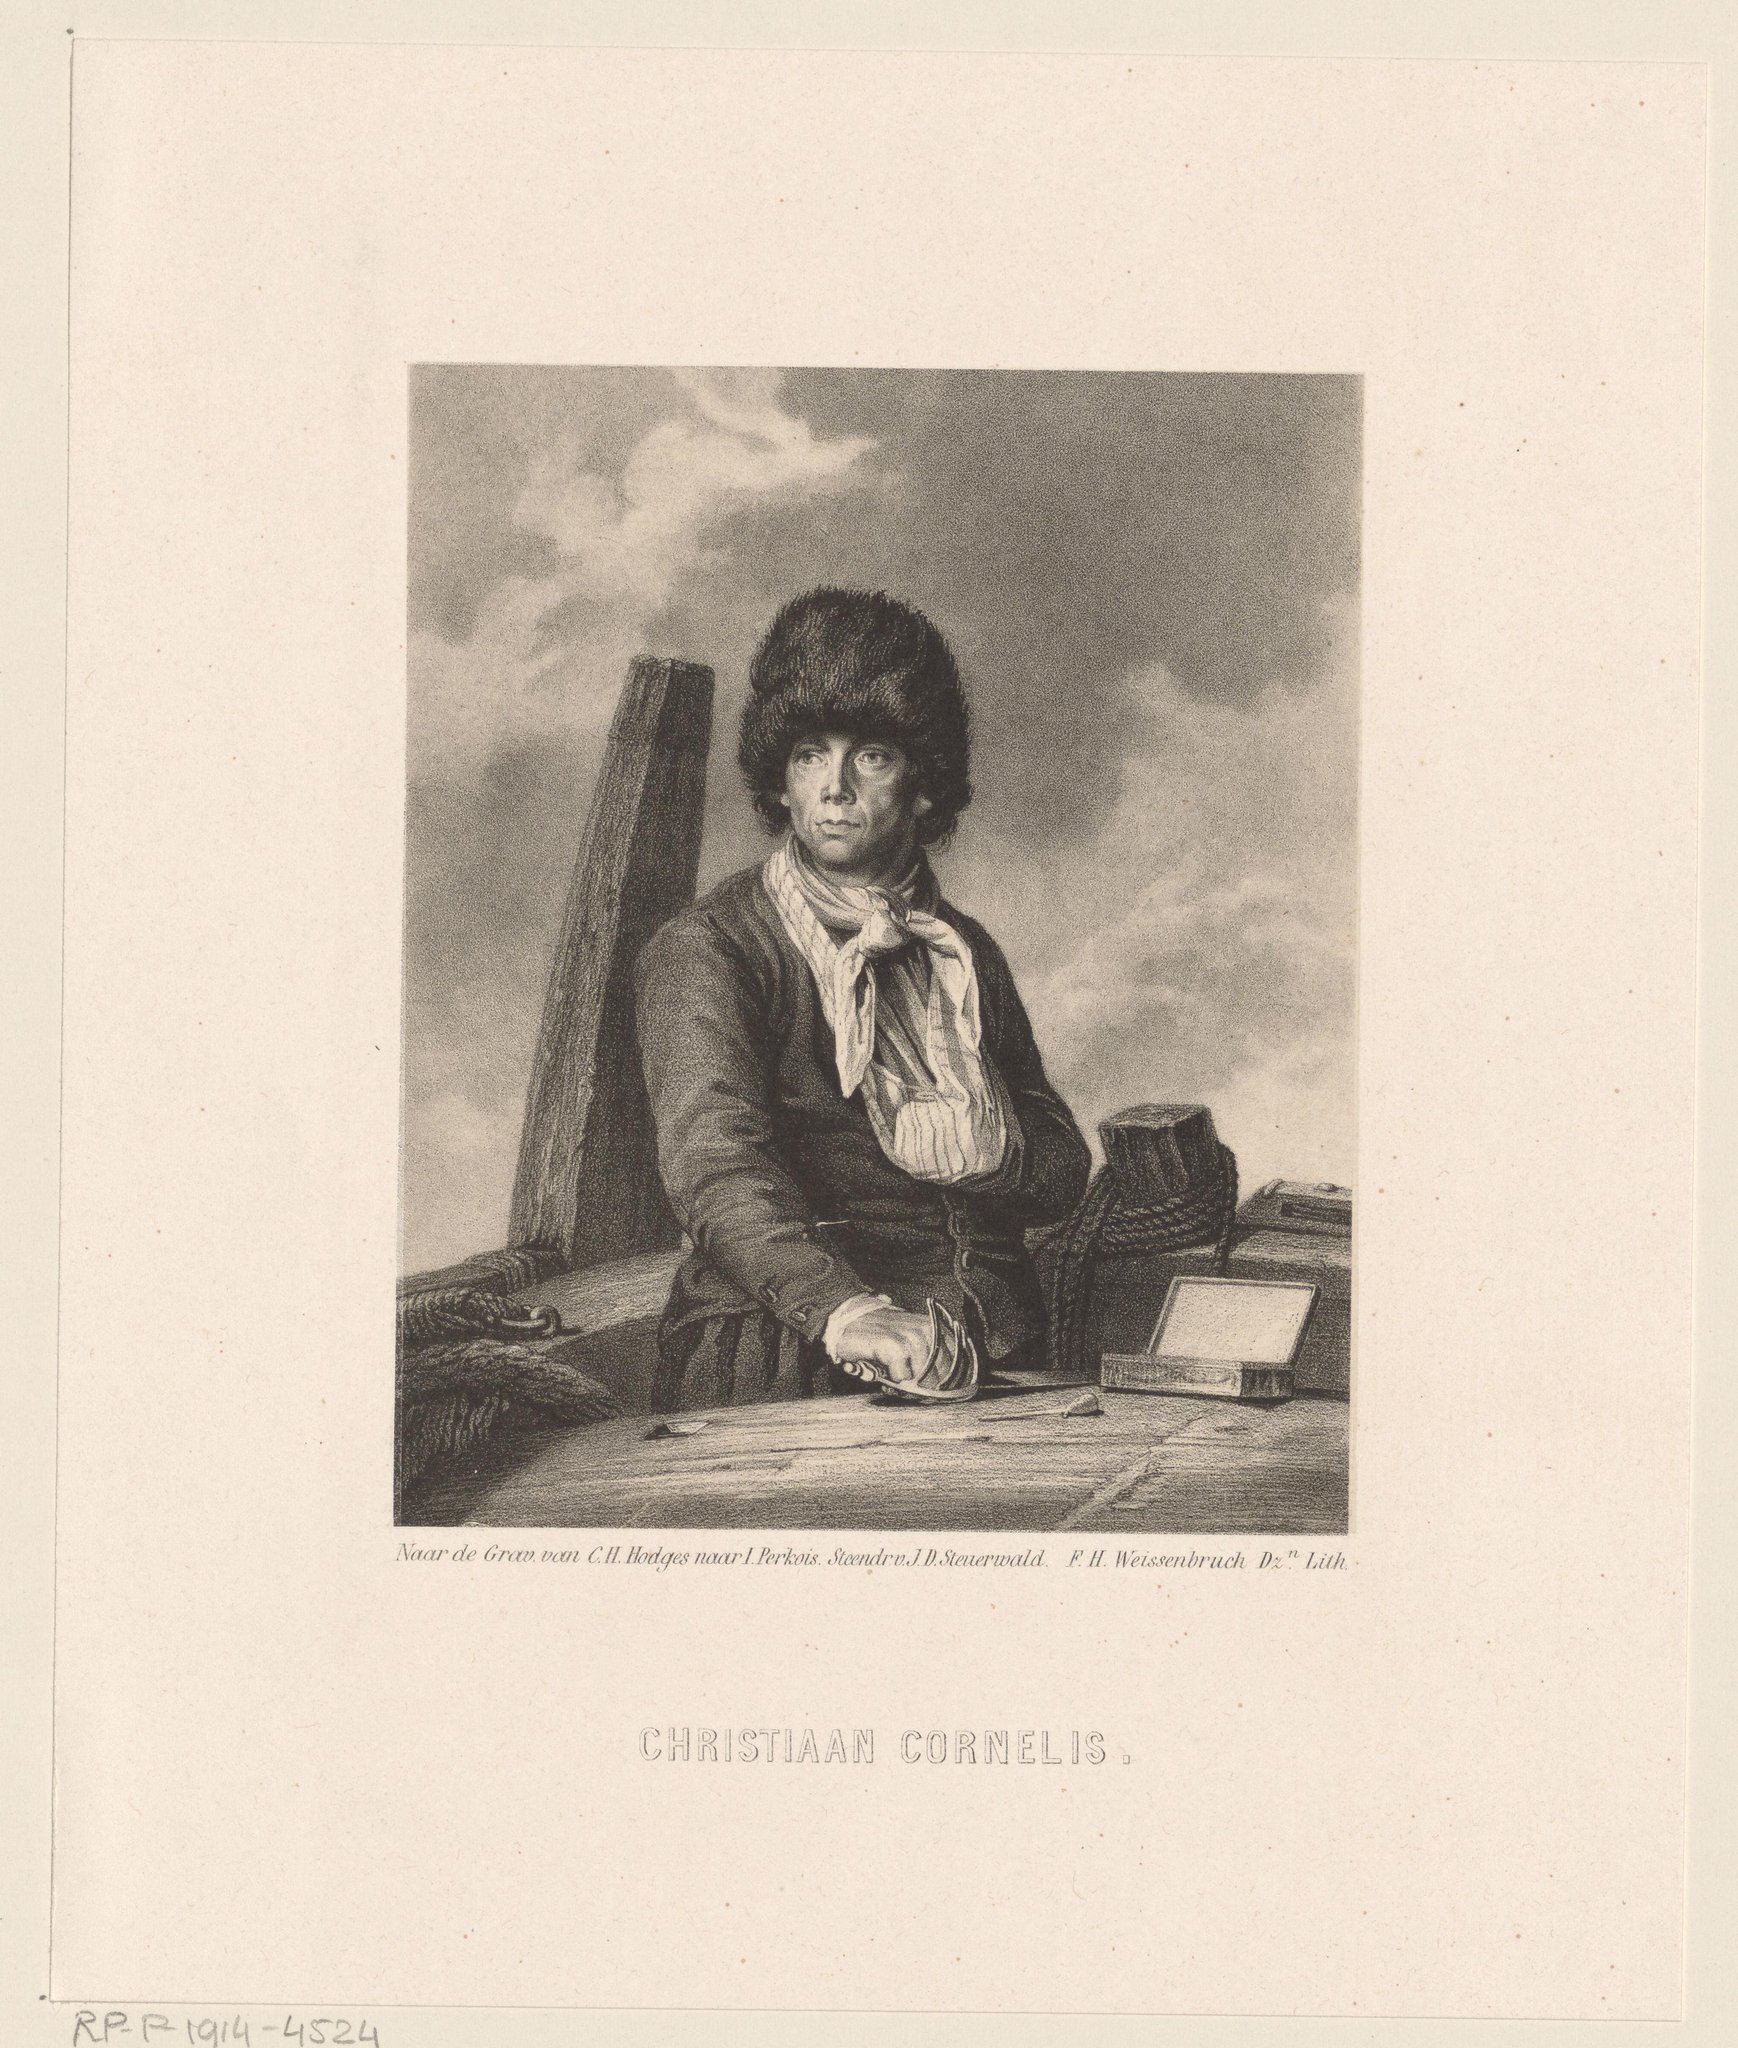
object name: print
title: Portret van Christiaan Cornelis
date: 1838-1887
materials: paper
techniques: lithograph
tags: historical persons, ships (in general)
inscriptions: collector's mark: Lugt 2228